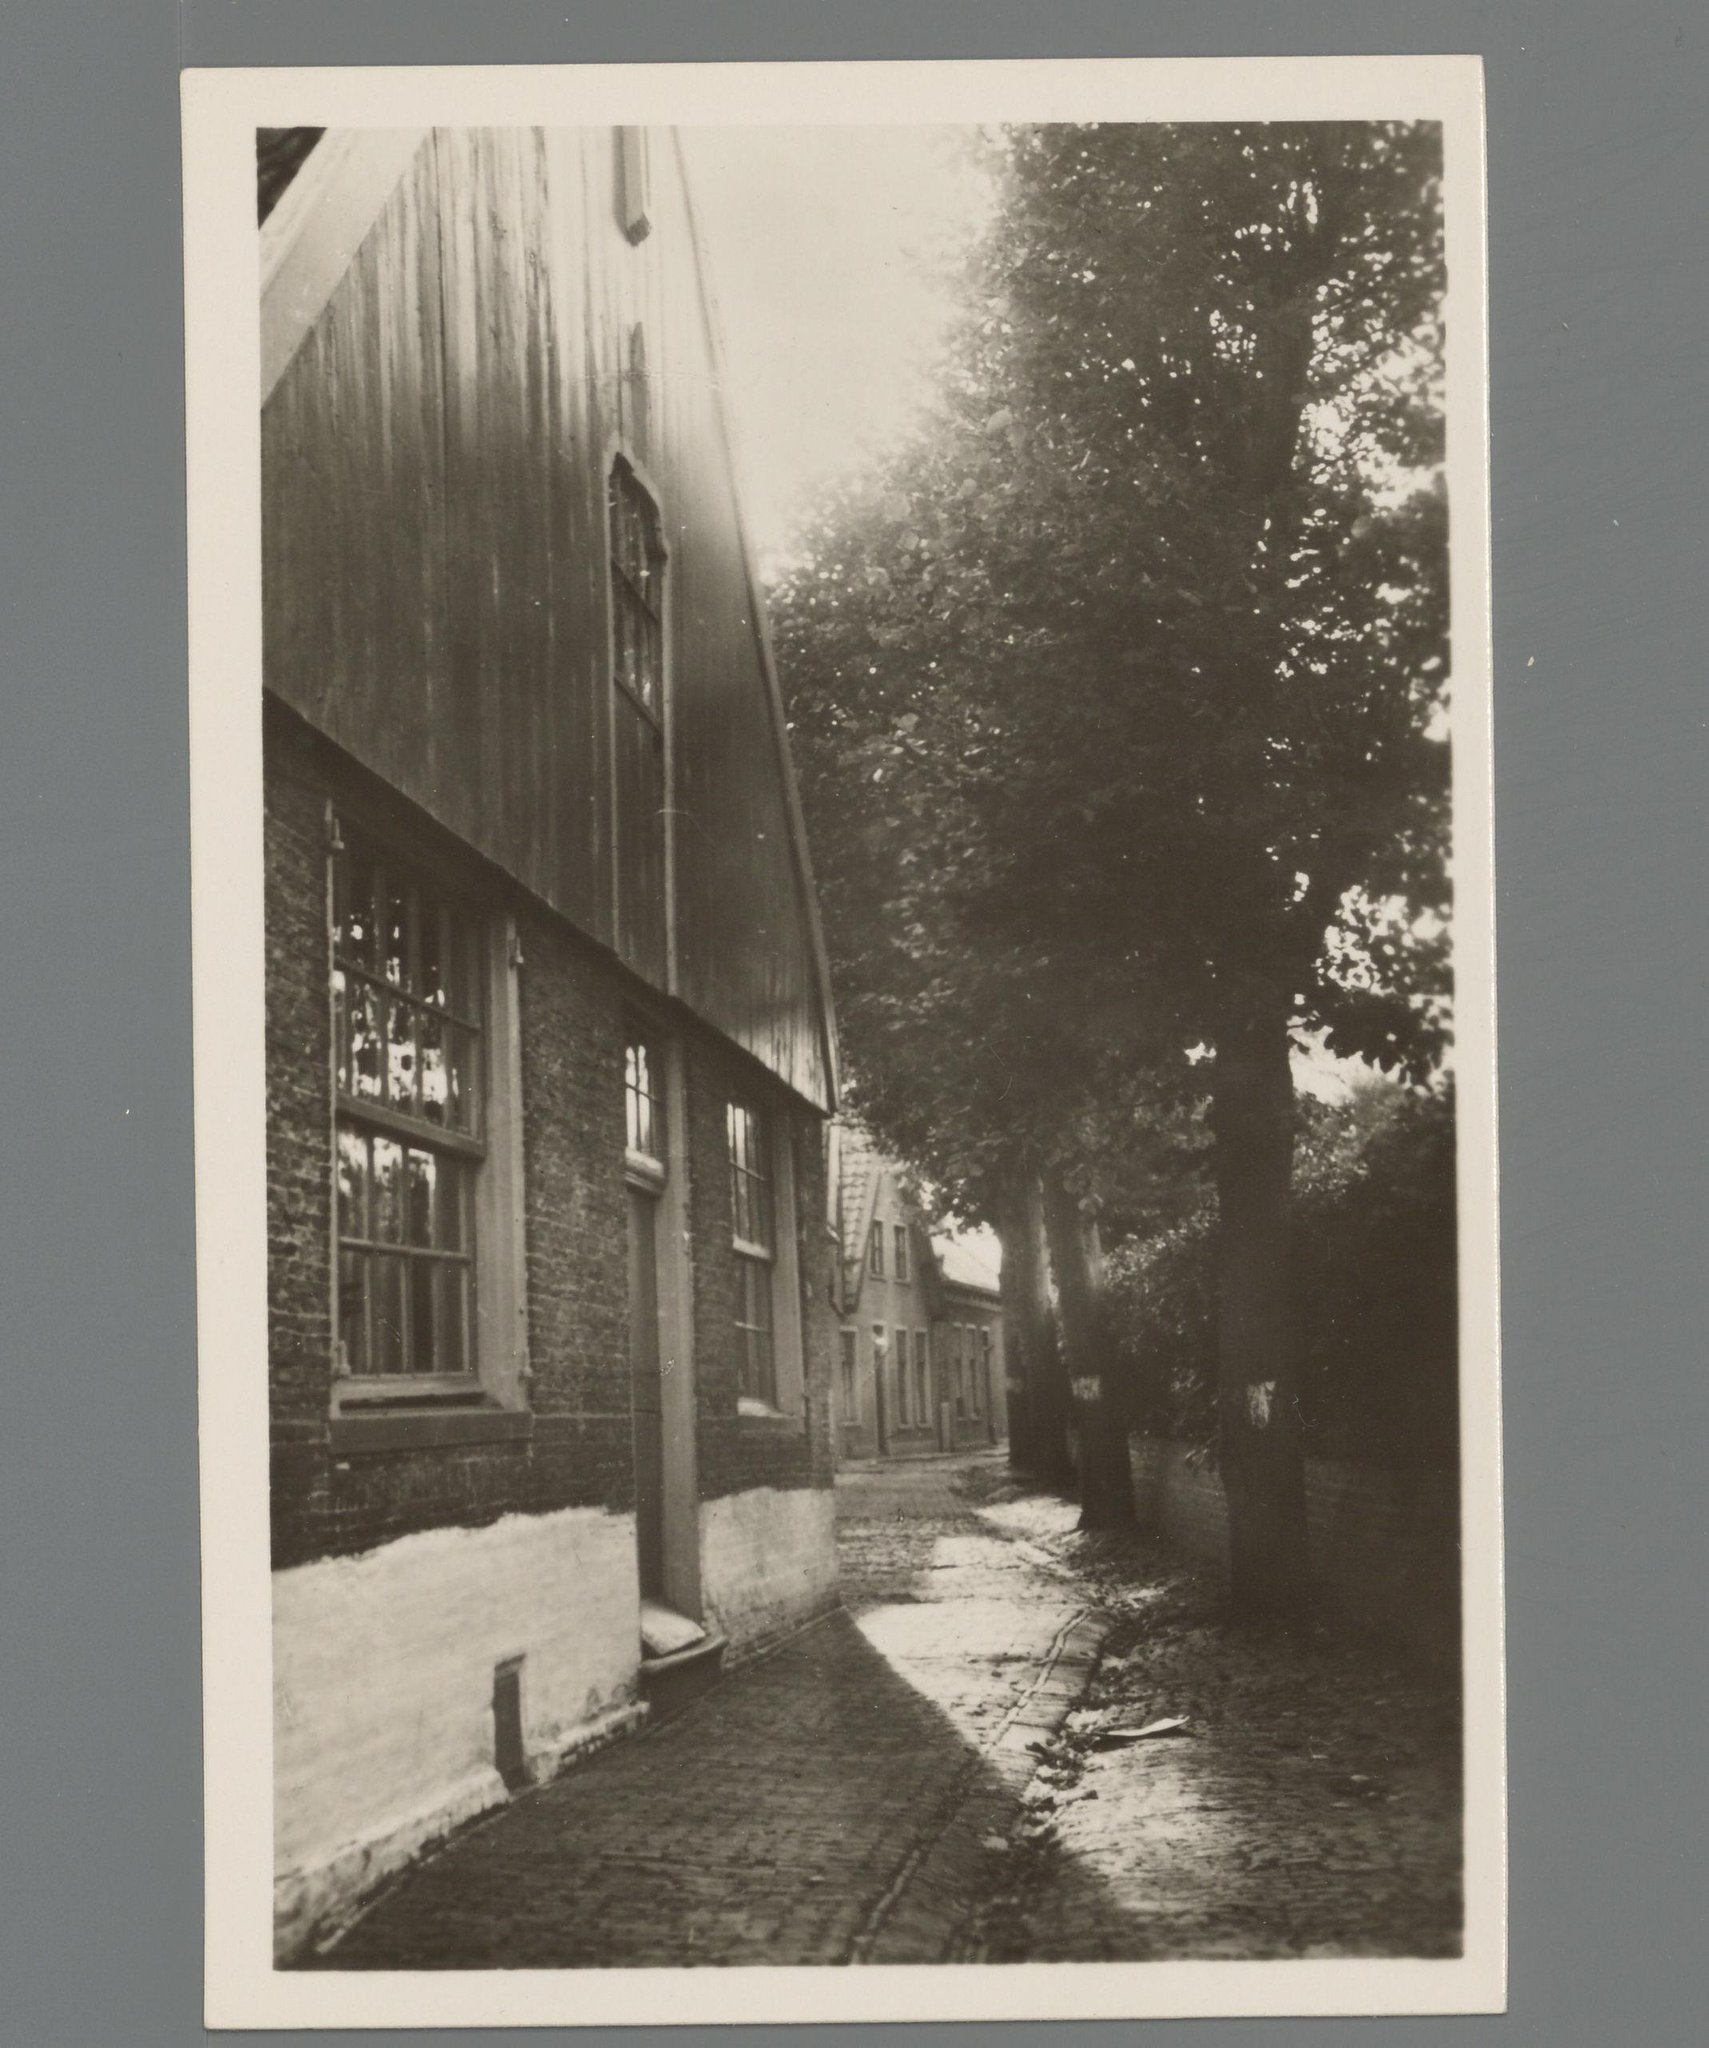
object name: ansichtkaart, prentbriefkaart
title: Texel. Kerkplein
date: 1904-1948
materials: photographic support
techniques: gelatin silver print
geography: den burg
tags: street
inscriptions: date